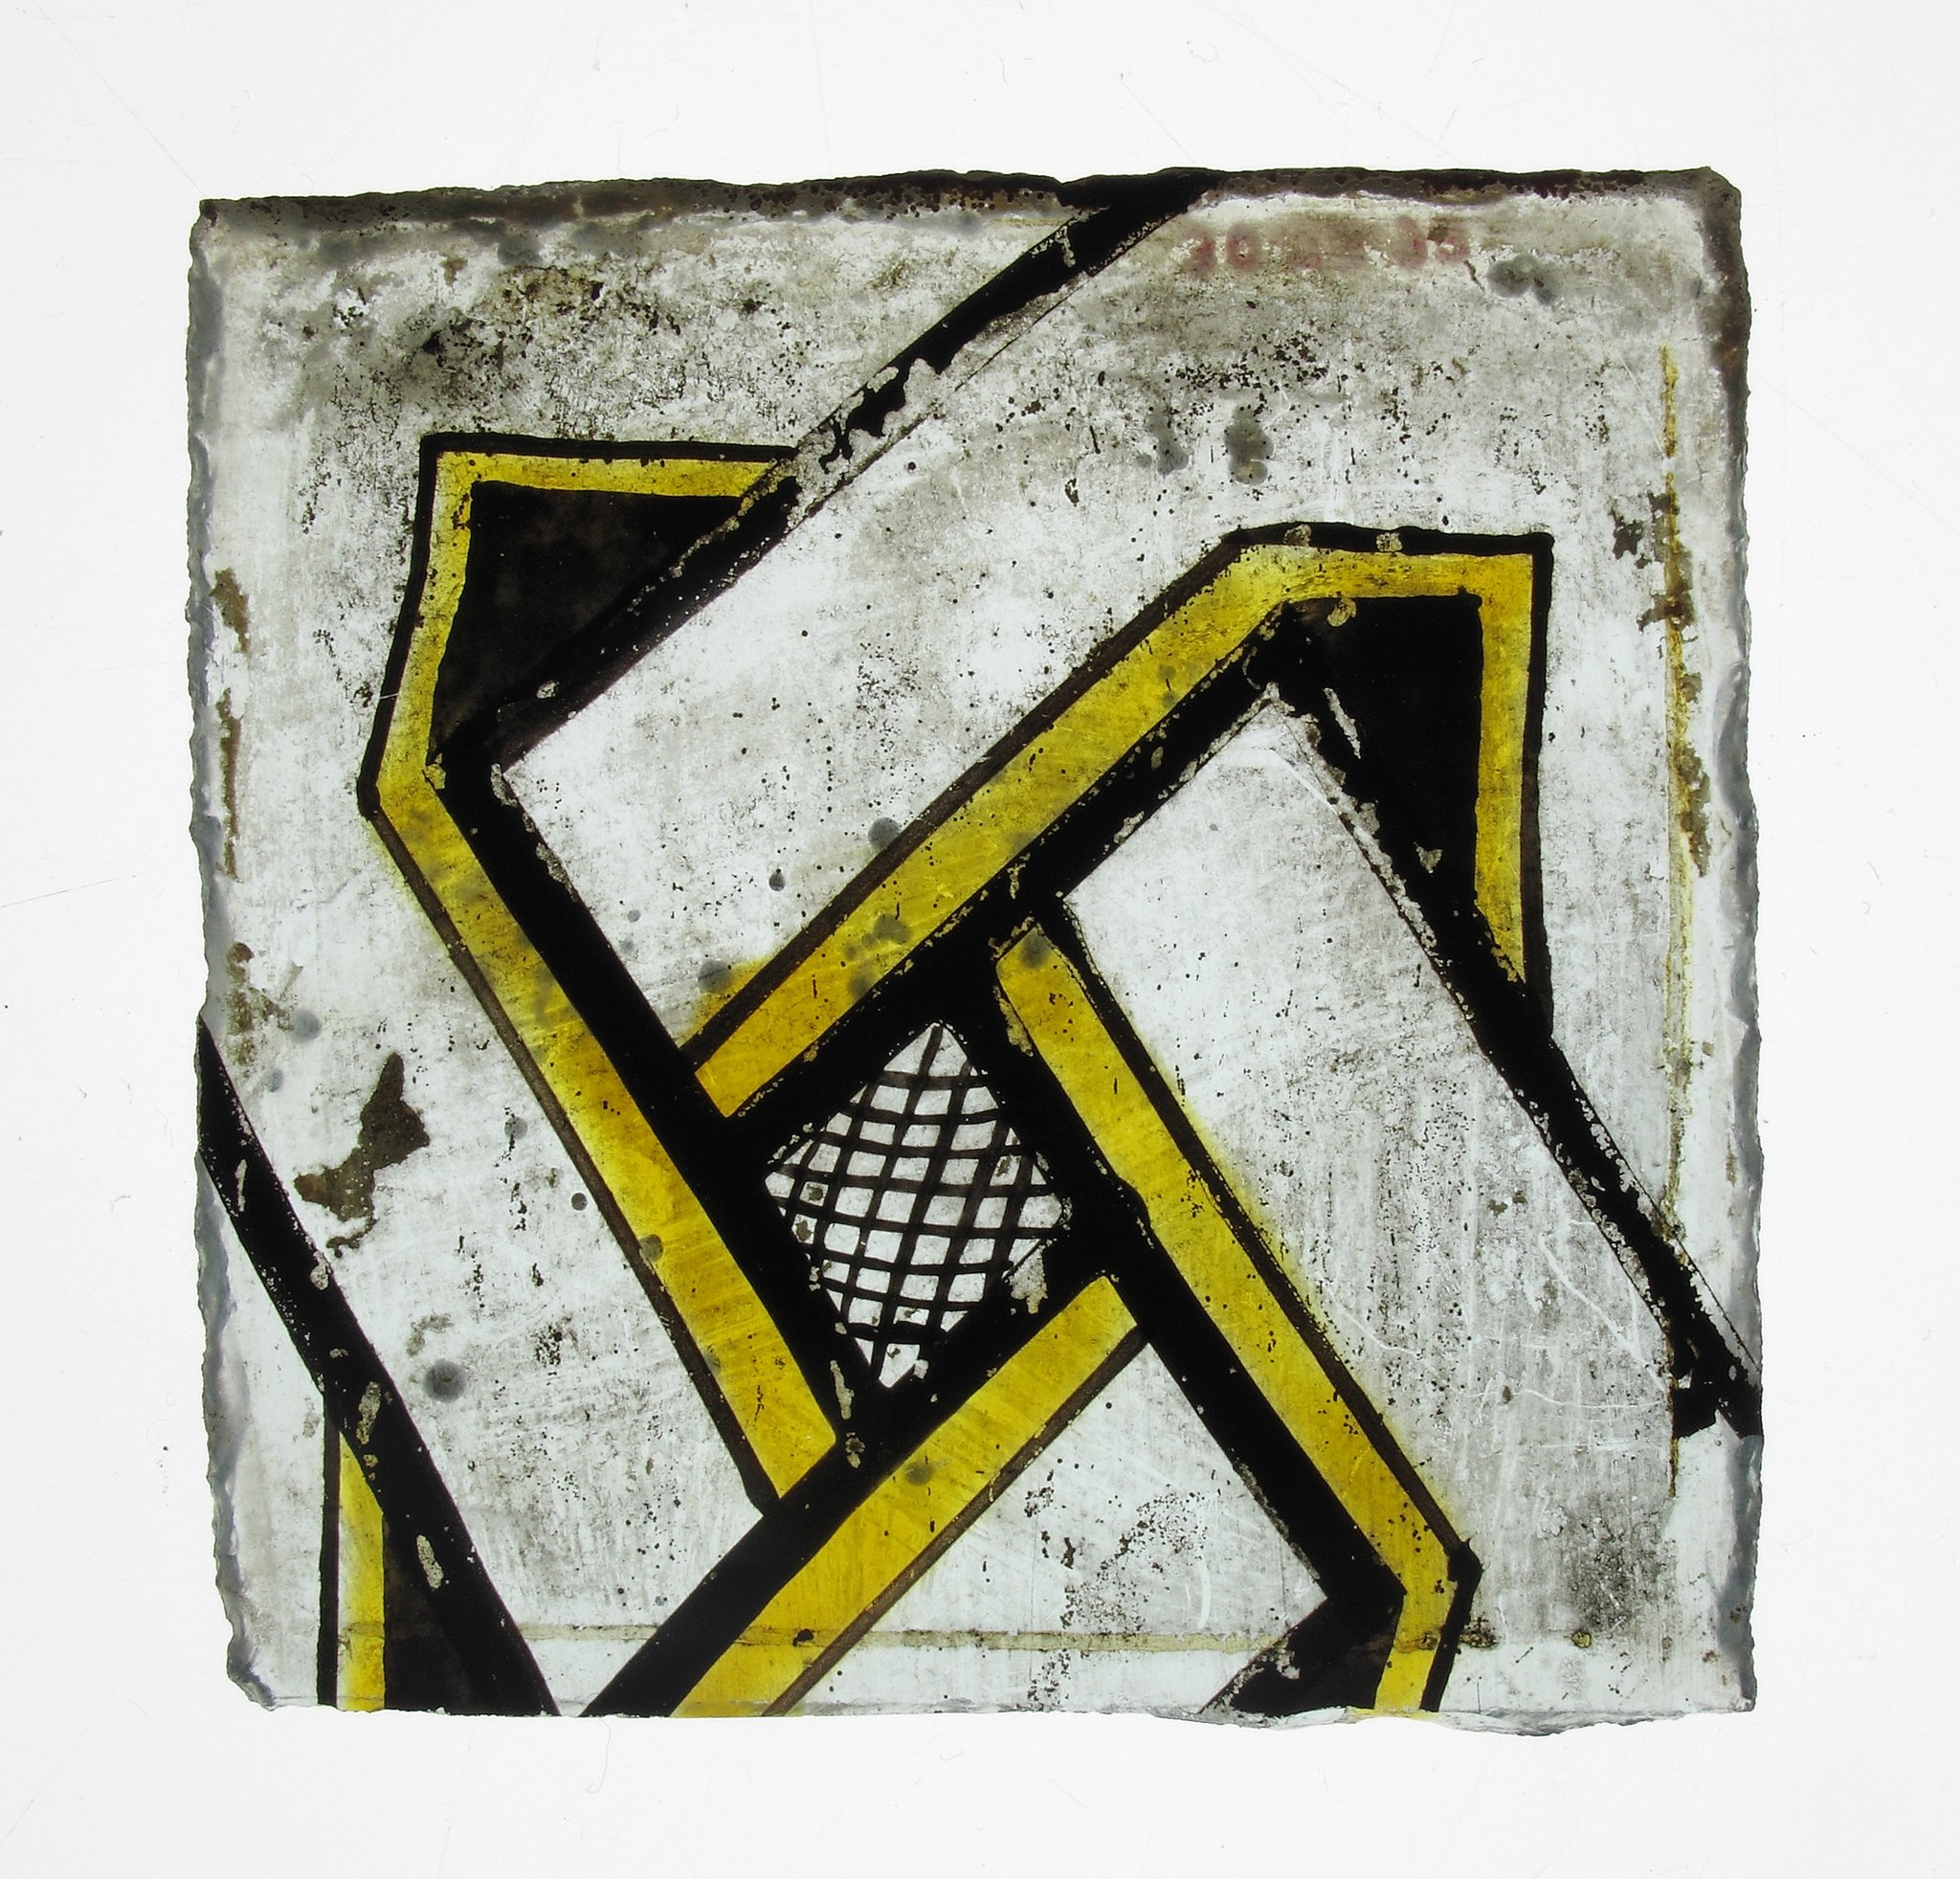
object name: fragment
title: Glass Fragment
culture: european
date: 1401-1500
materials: glass, pigment